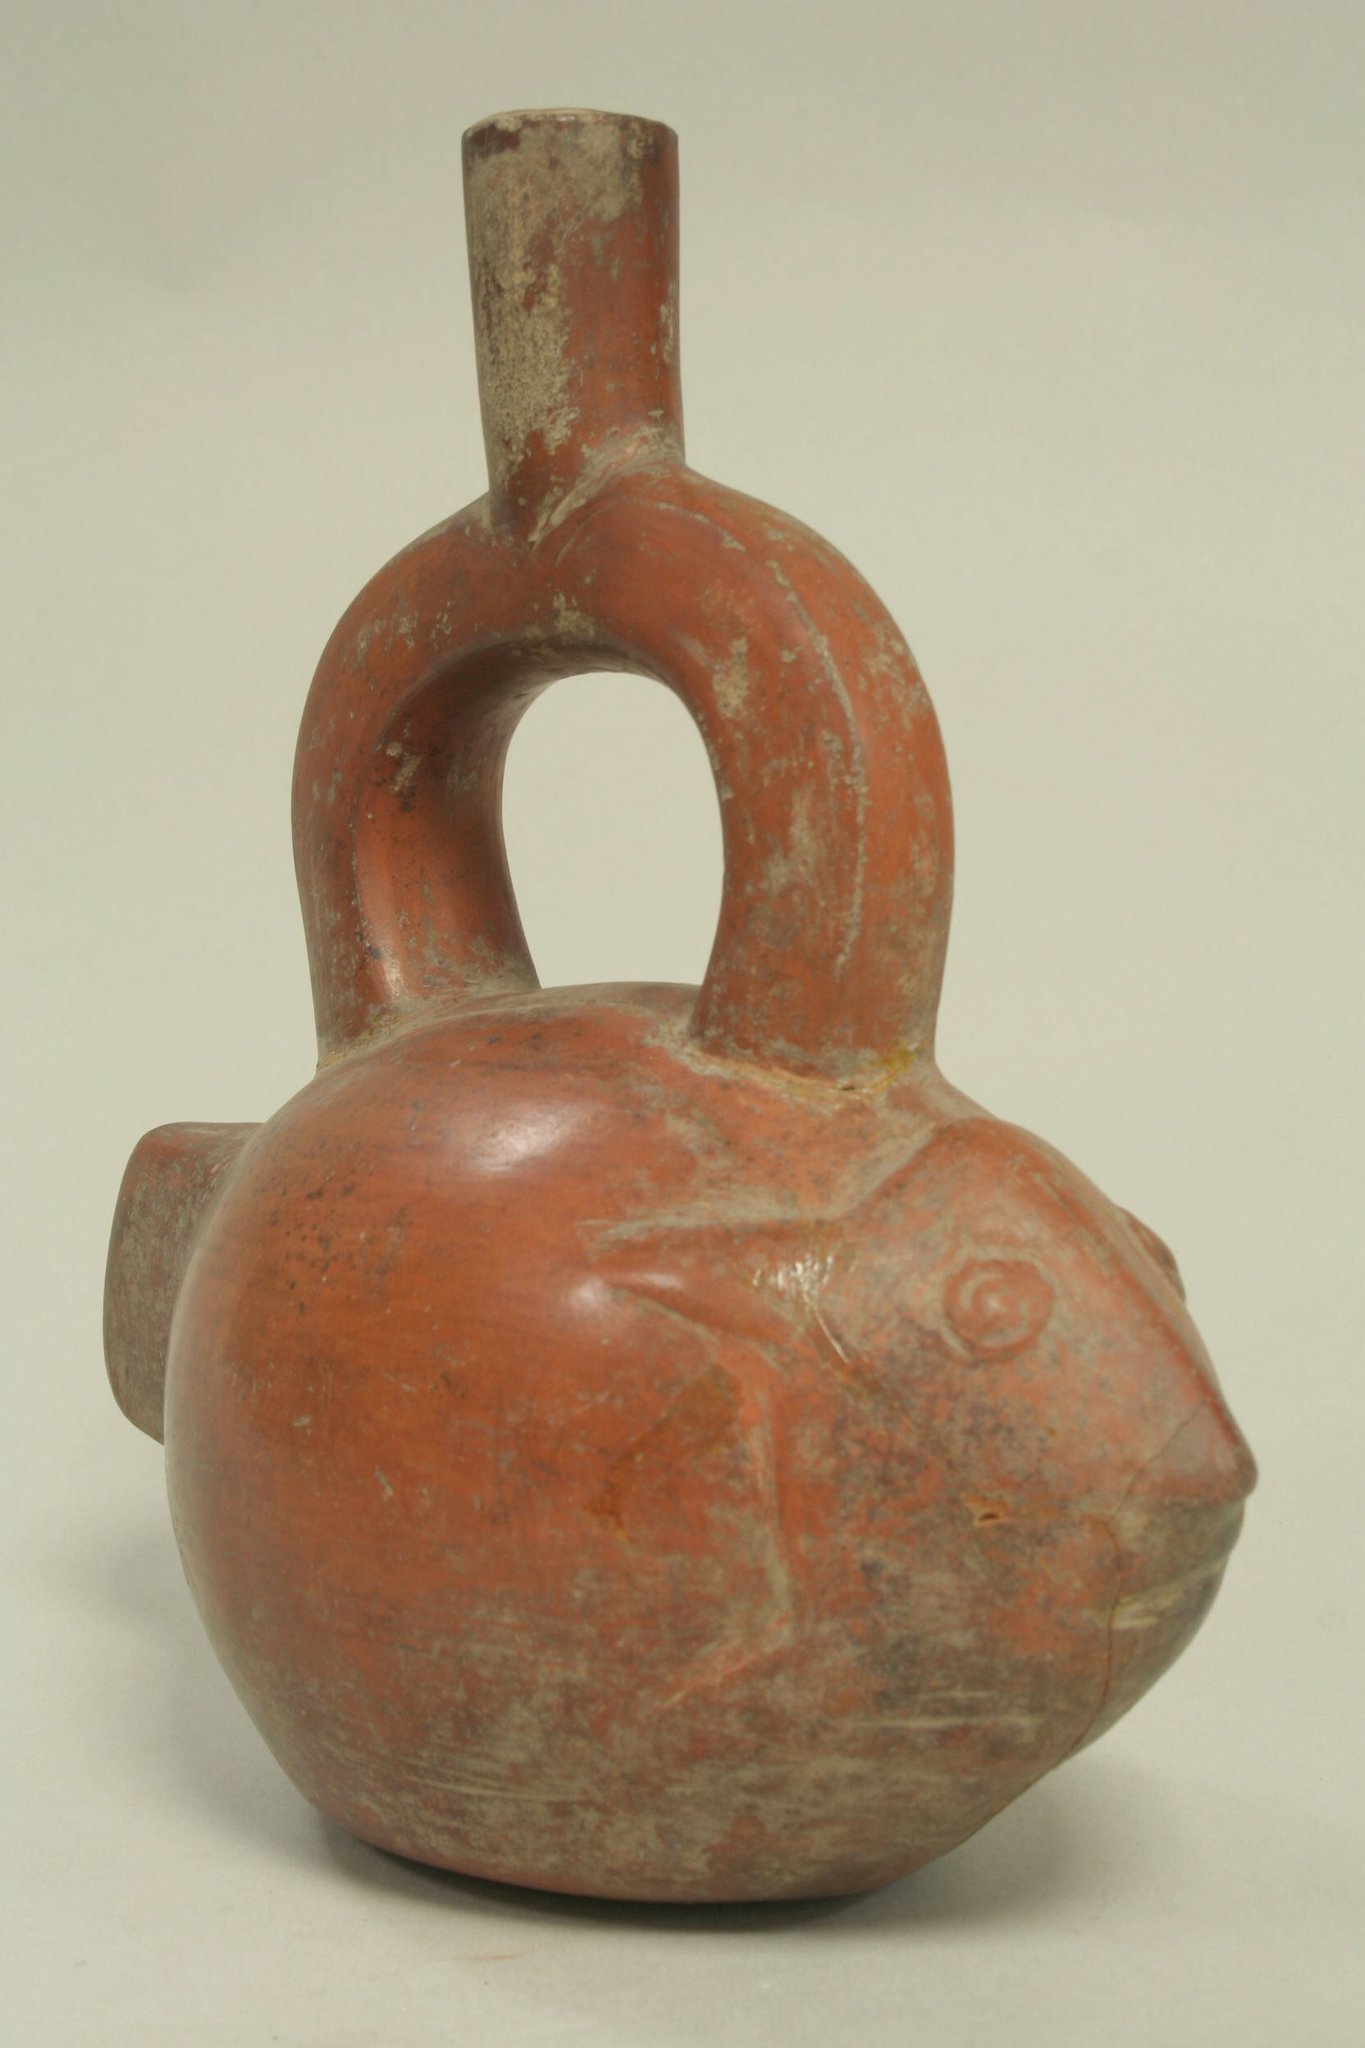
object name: bottle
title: Stirrup Spout Bottle with Fish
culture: chimú or inca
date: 1301-1600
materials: ceramic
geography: peru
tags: fish